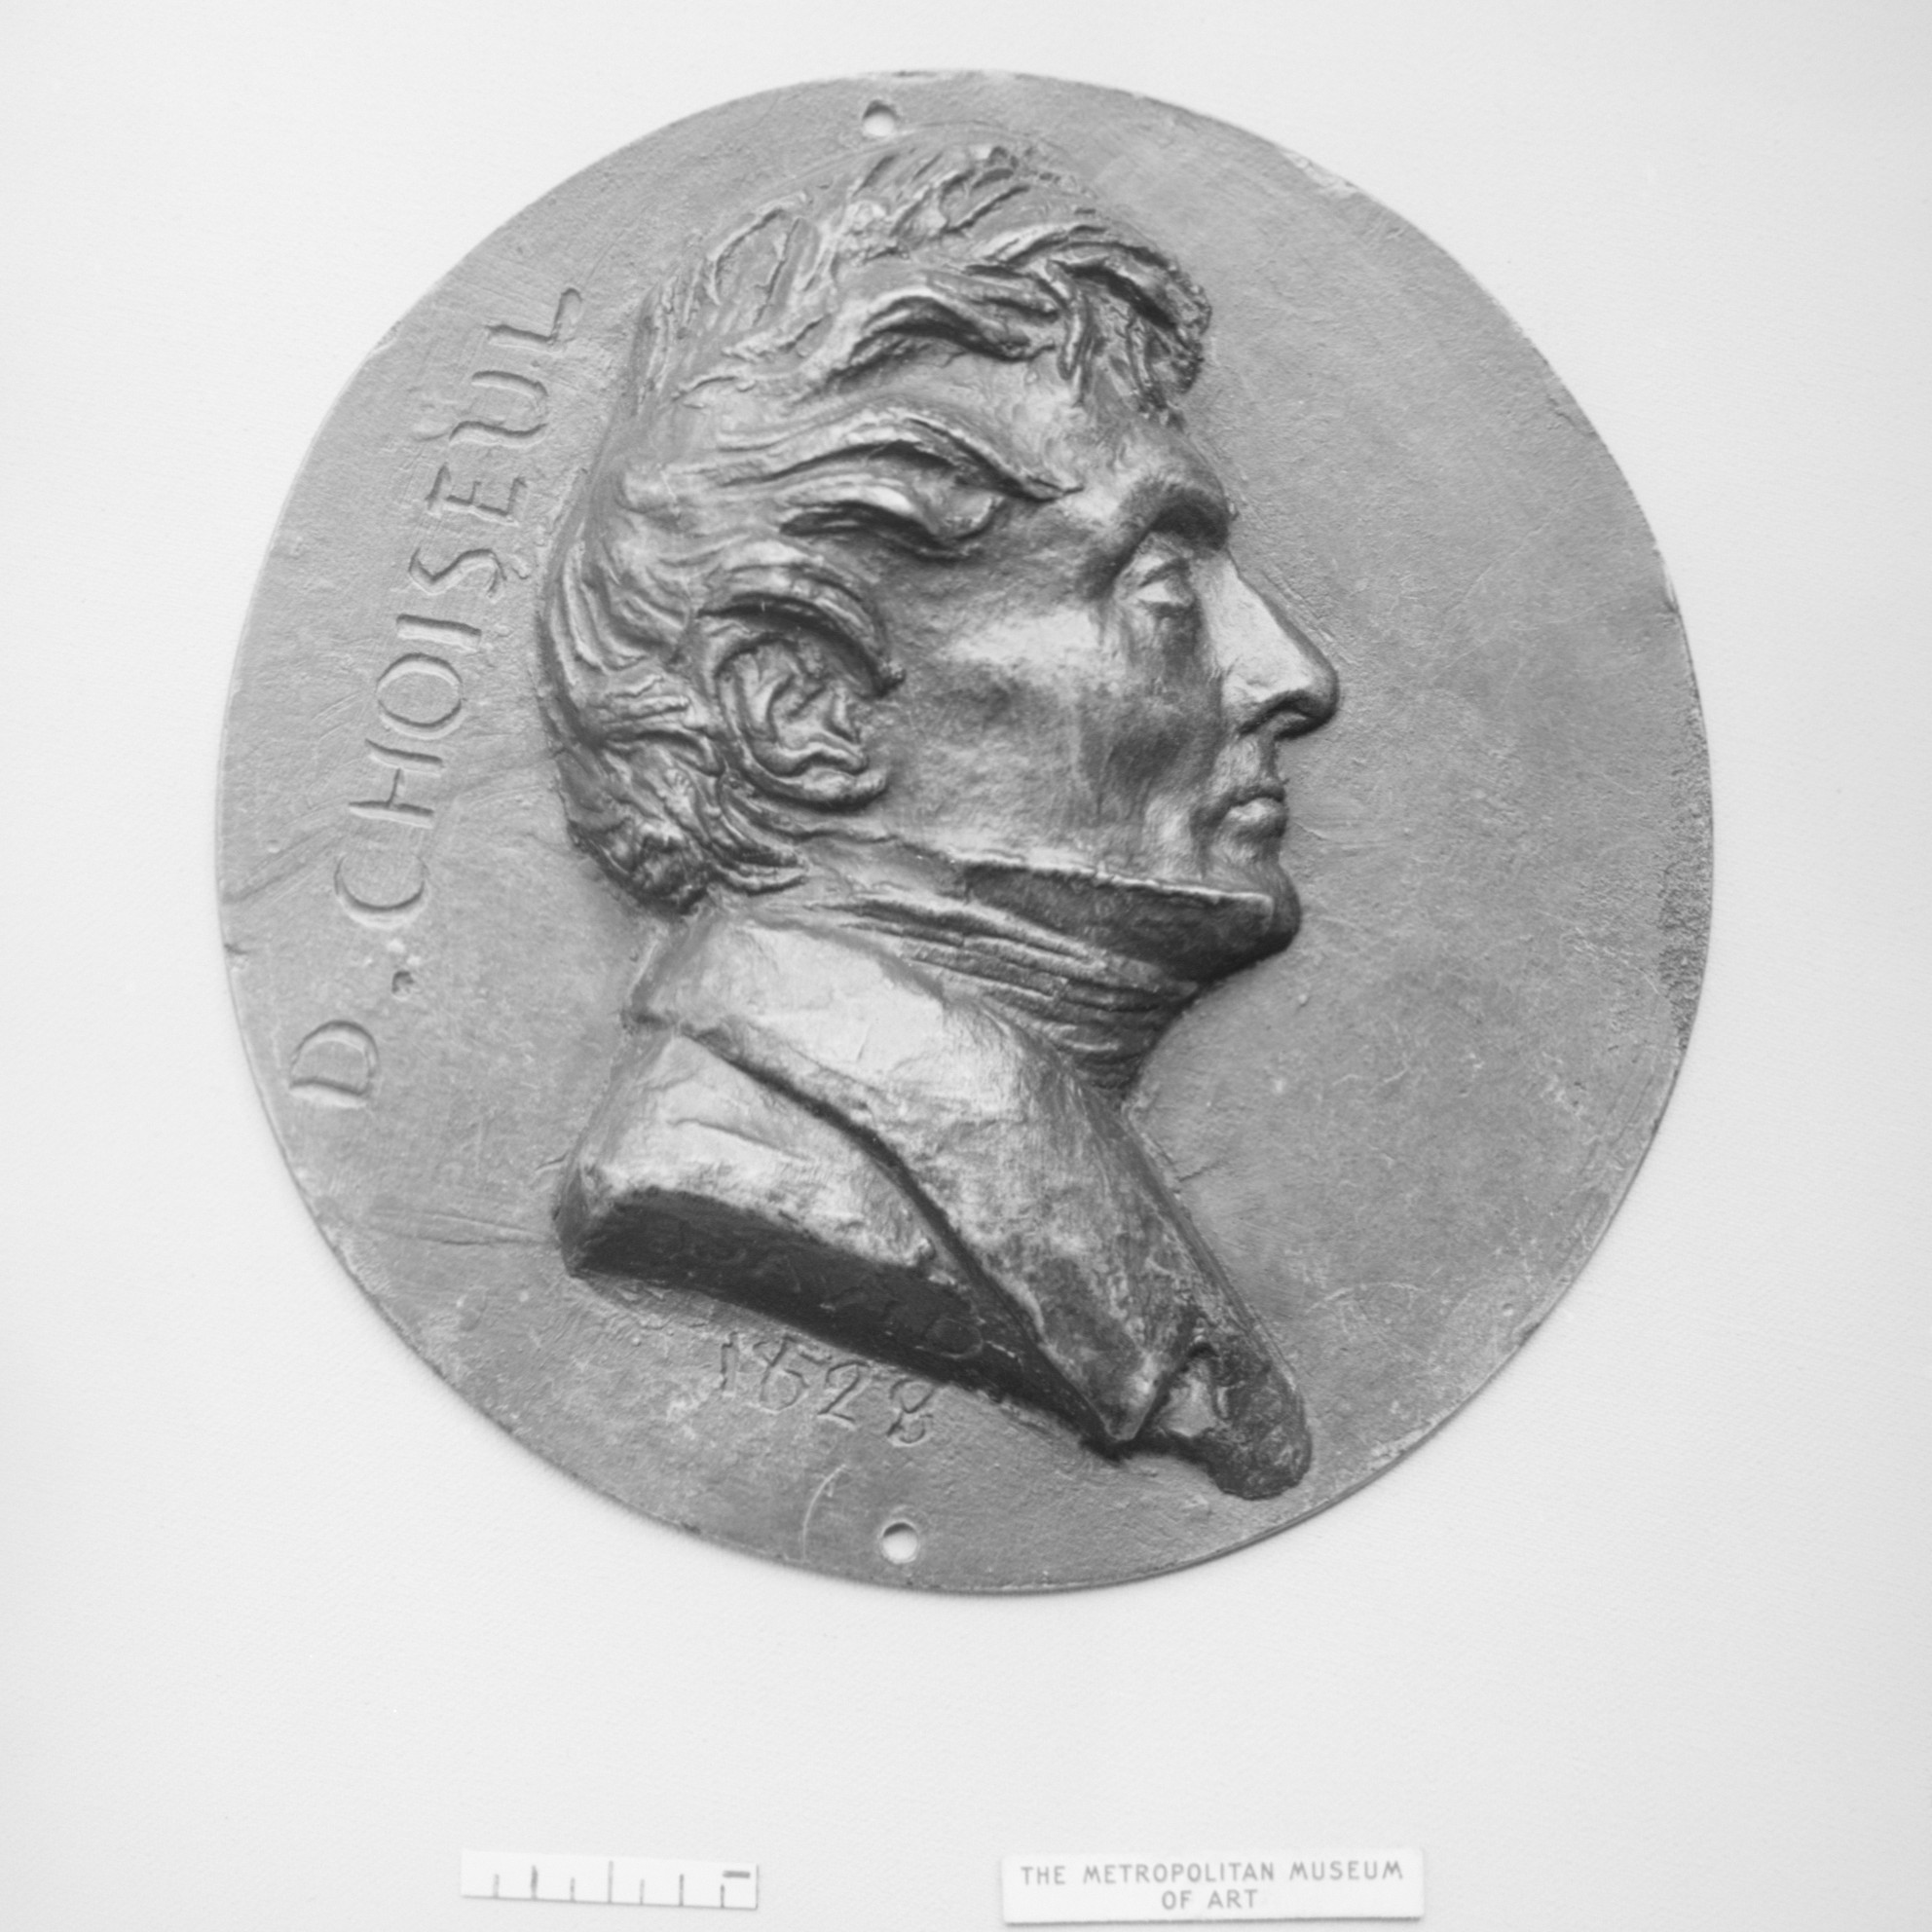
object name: medallion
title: Claude Antoine Gabriel de Choiseul, duc et Pair de France (1760–1838)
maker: pierre jean david d'angers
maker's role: artist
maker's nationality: french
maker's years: 1788-1856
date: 1828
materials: bronze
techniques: casting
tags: men,profiles